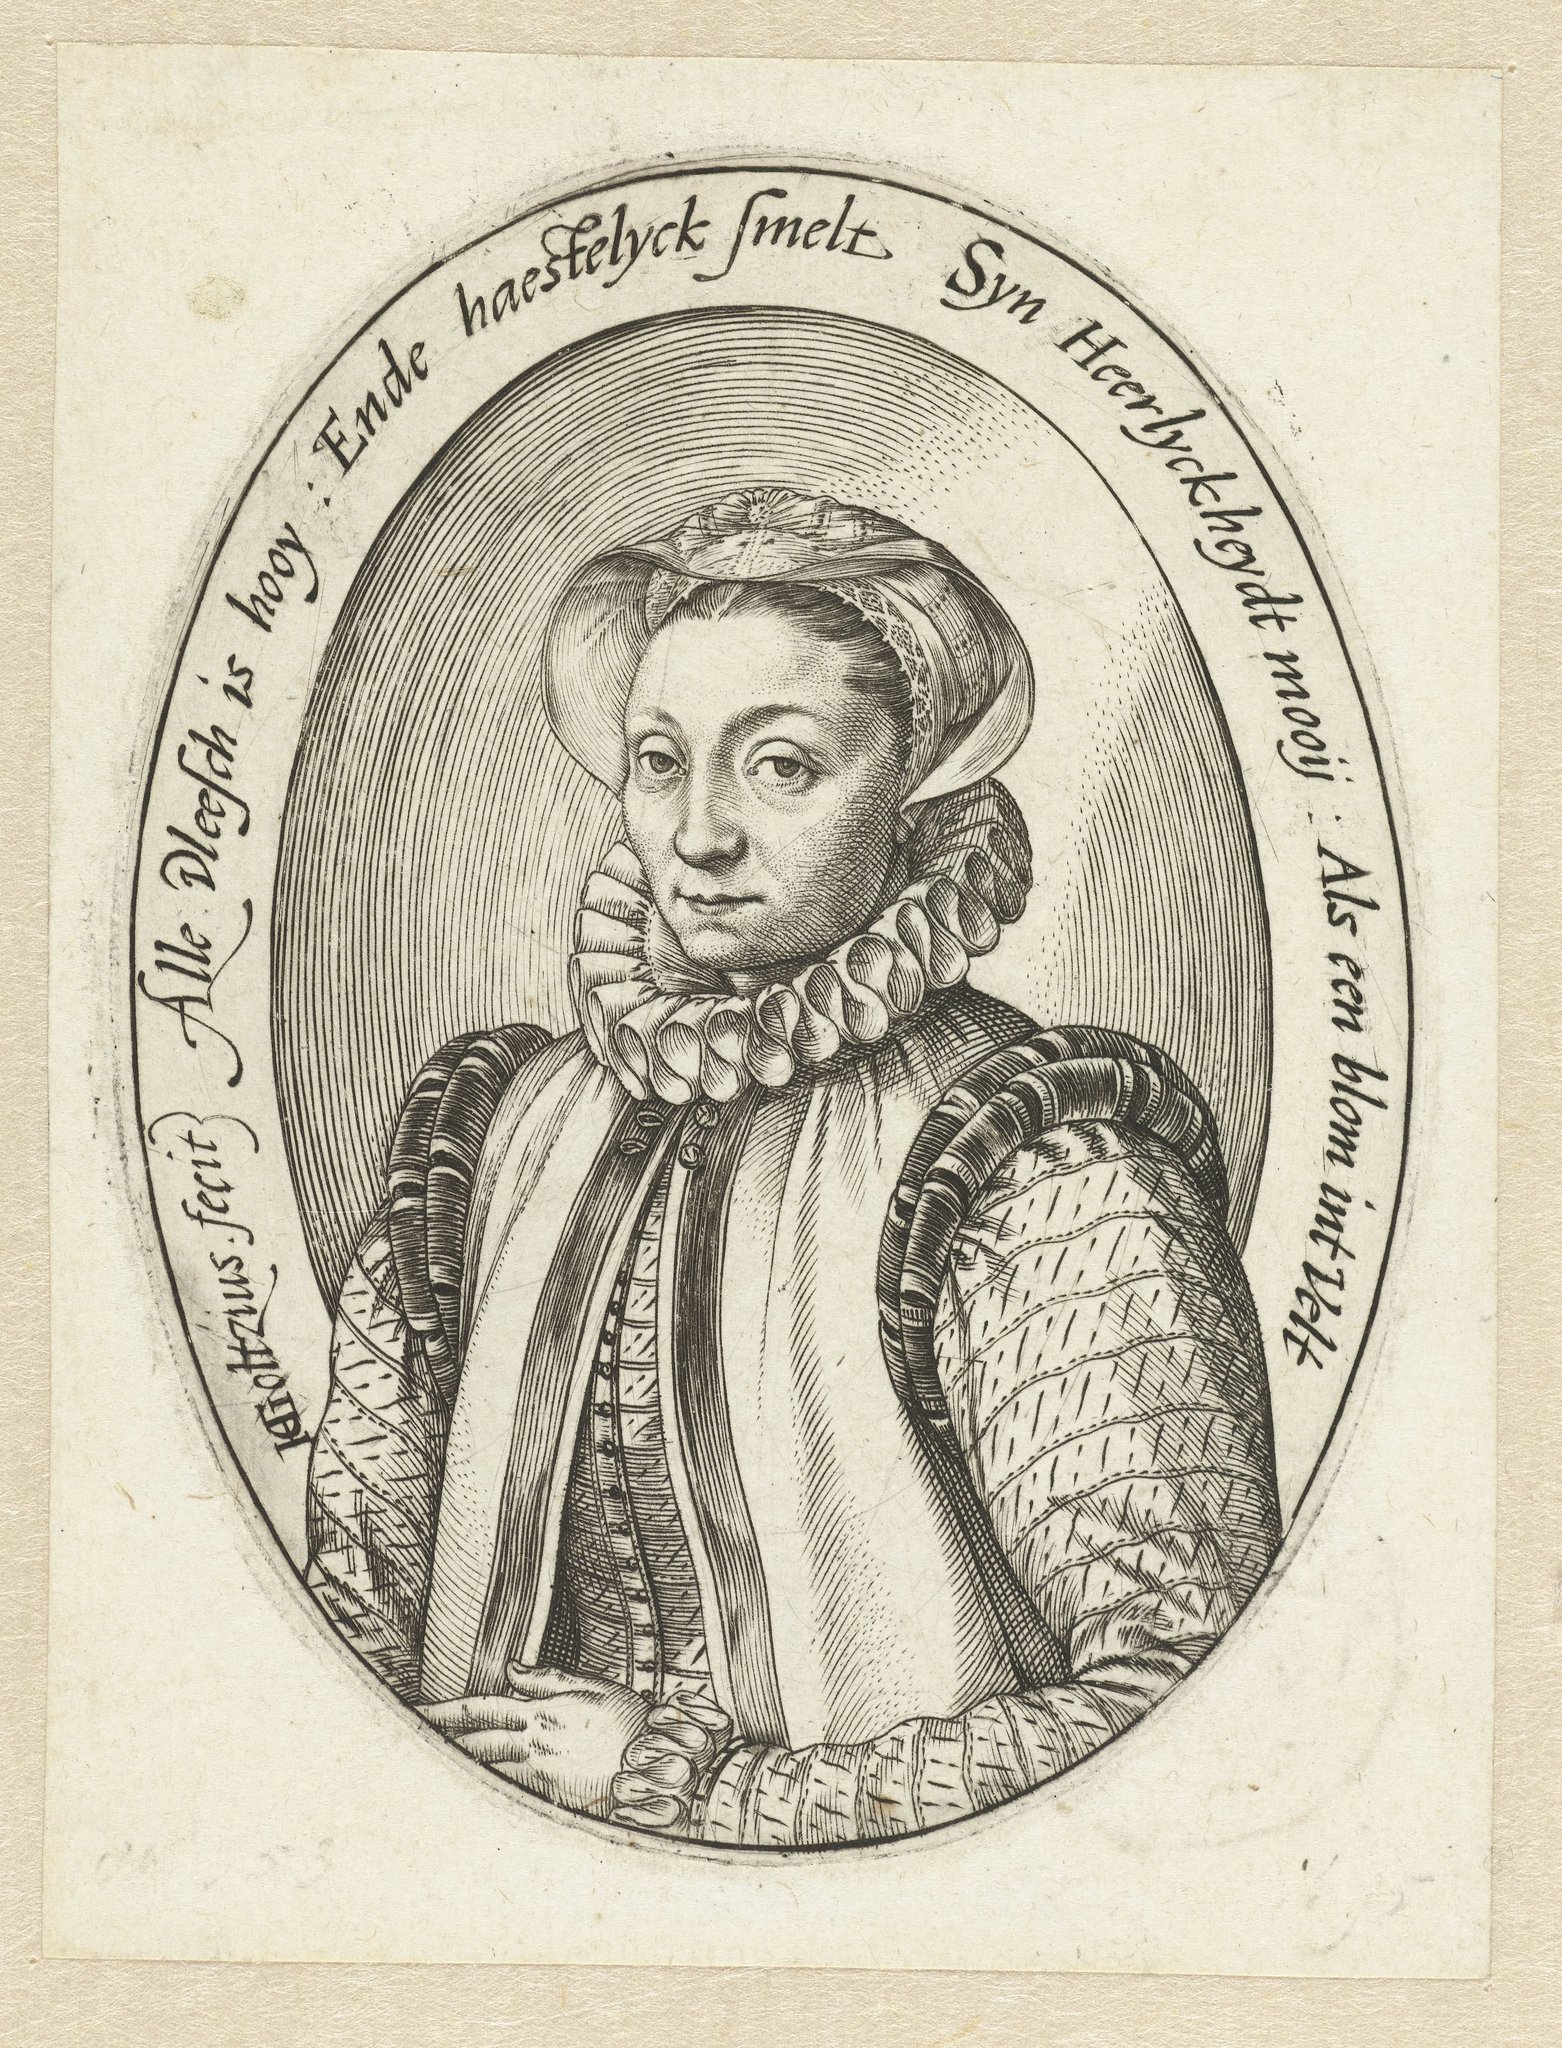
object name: print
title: Portret van een vrouw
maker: hendrick goltzius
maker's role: draughtsman, painter, print maker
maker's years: 1558-1617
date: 1581-1585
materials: paper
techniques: engraving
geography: haarlem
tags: anonymous historical person portrayed alone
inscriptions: collector's mark: Lugt 240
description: Ovaal portret van een vrouw, ten halven lijve, de linkerhand nog net zichtbaar, met geplooide kraag. Om de voorstelling randschrift in het Nederlands. Pendant van soortgelijk portret van een man.